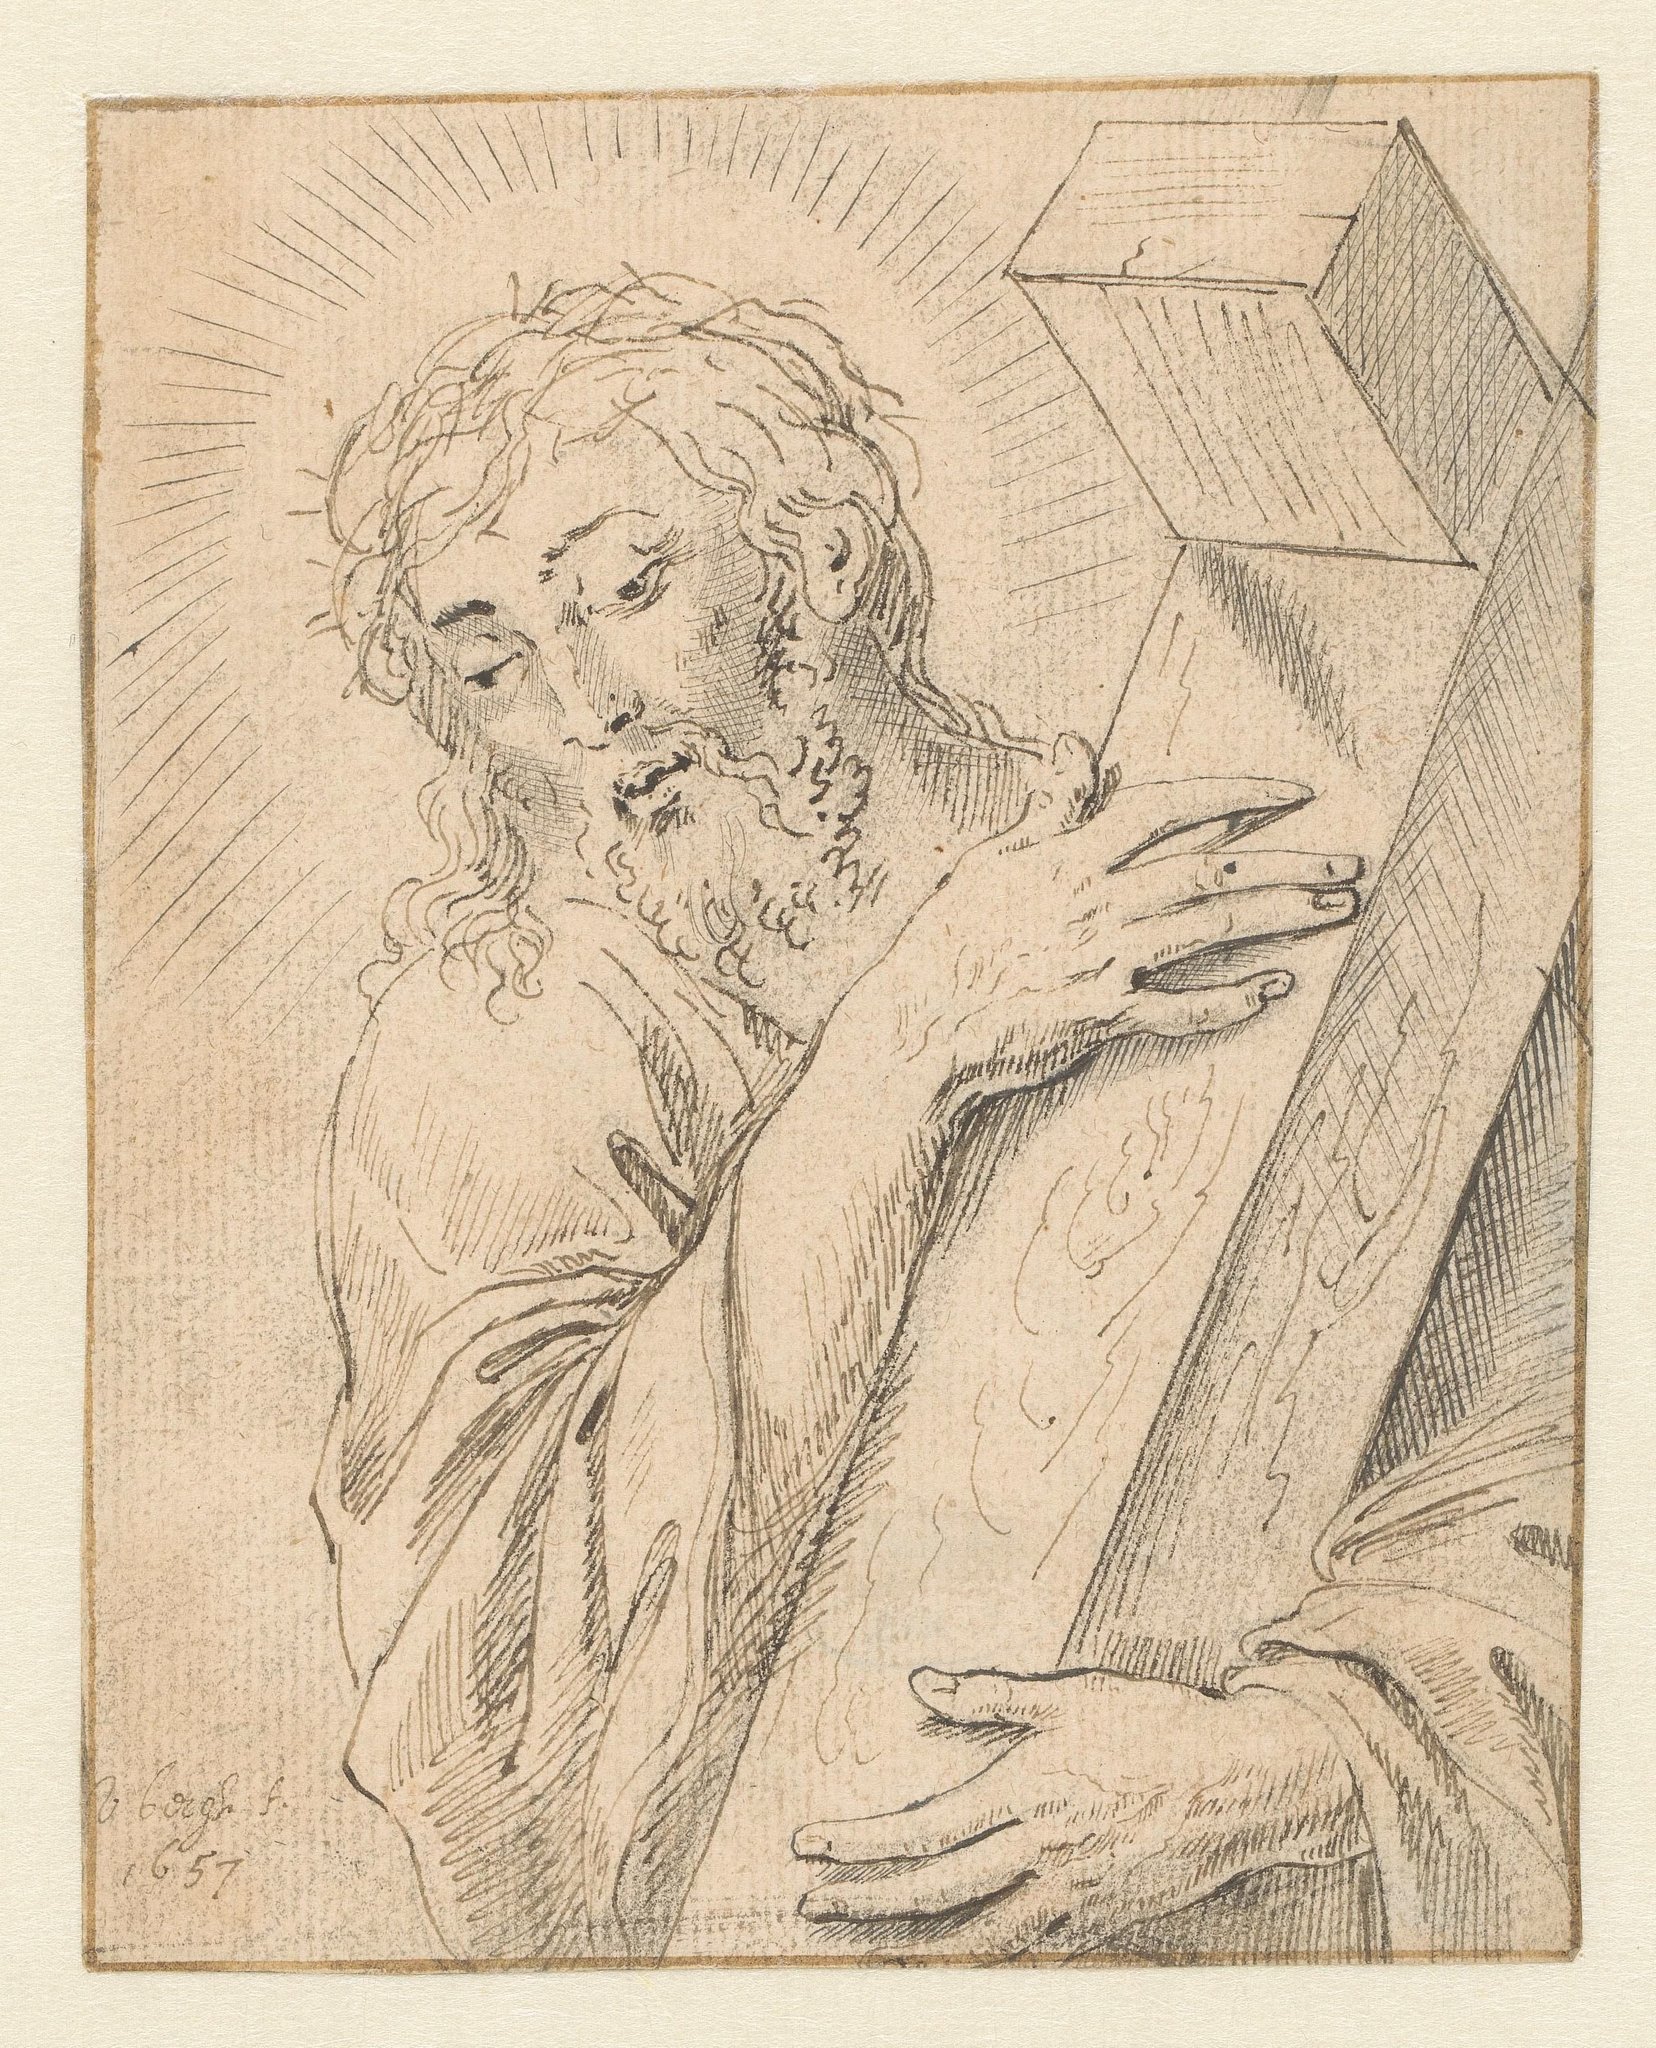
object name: drawing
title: Christus met de doornenkroon en het kruis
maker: matthys van den bergh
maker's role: draughtsman, print maker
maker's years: 1617-1687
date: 1657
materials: ink, paper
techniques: pen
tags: particular types of adult christ (without others), carrying of the cross: christ bearing the cross, alone or with the help of others (e.g. simon the cyrenian)